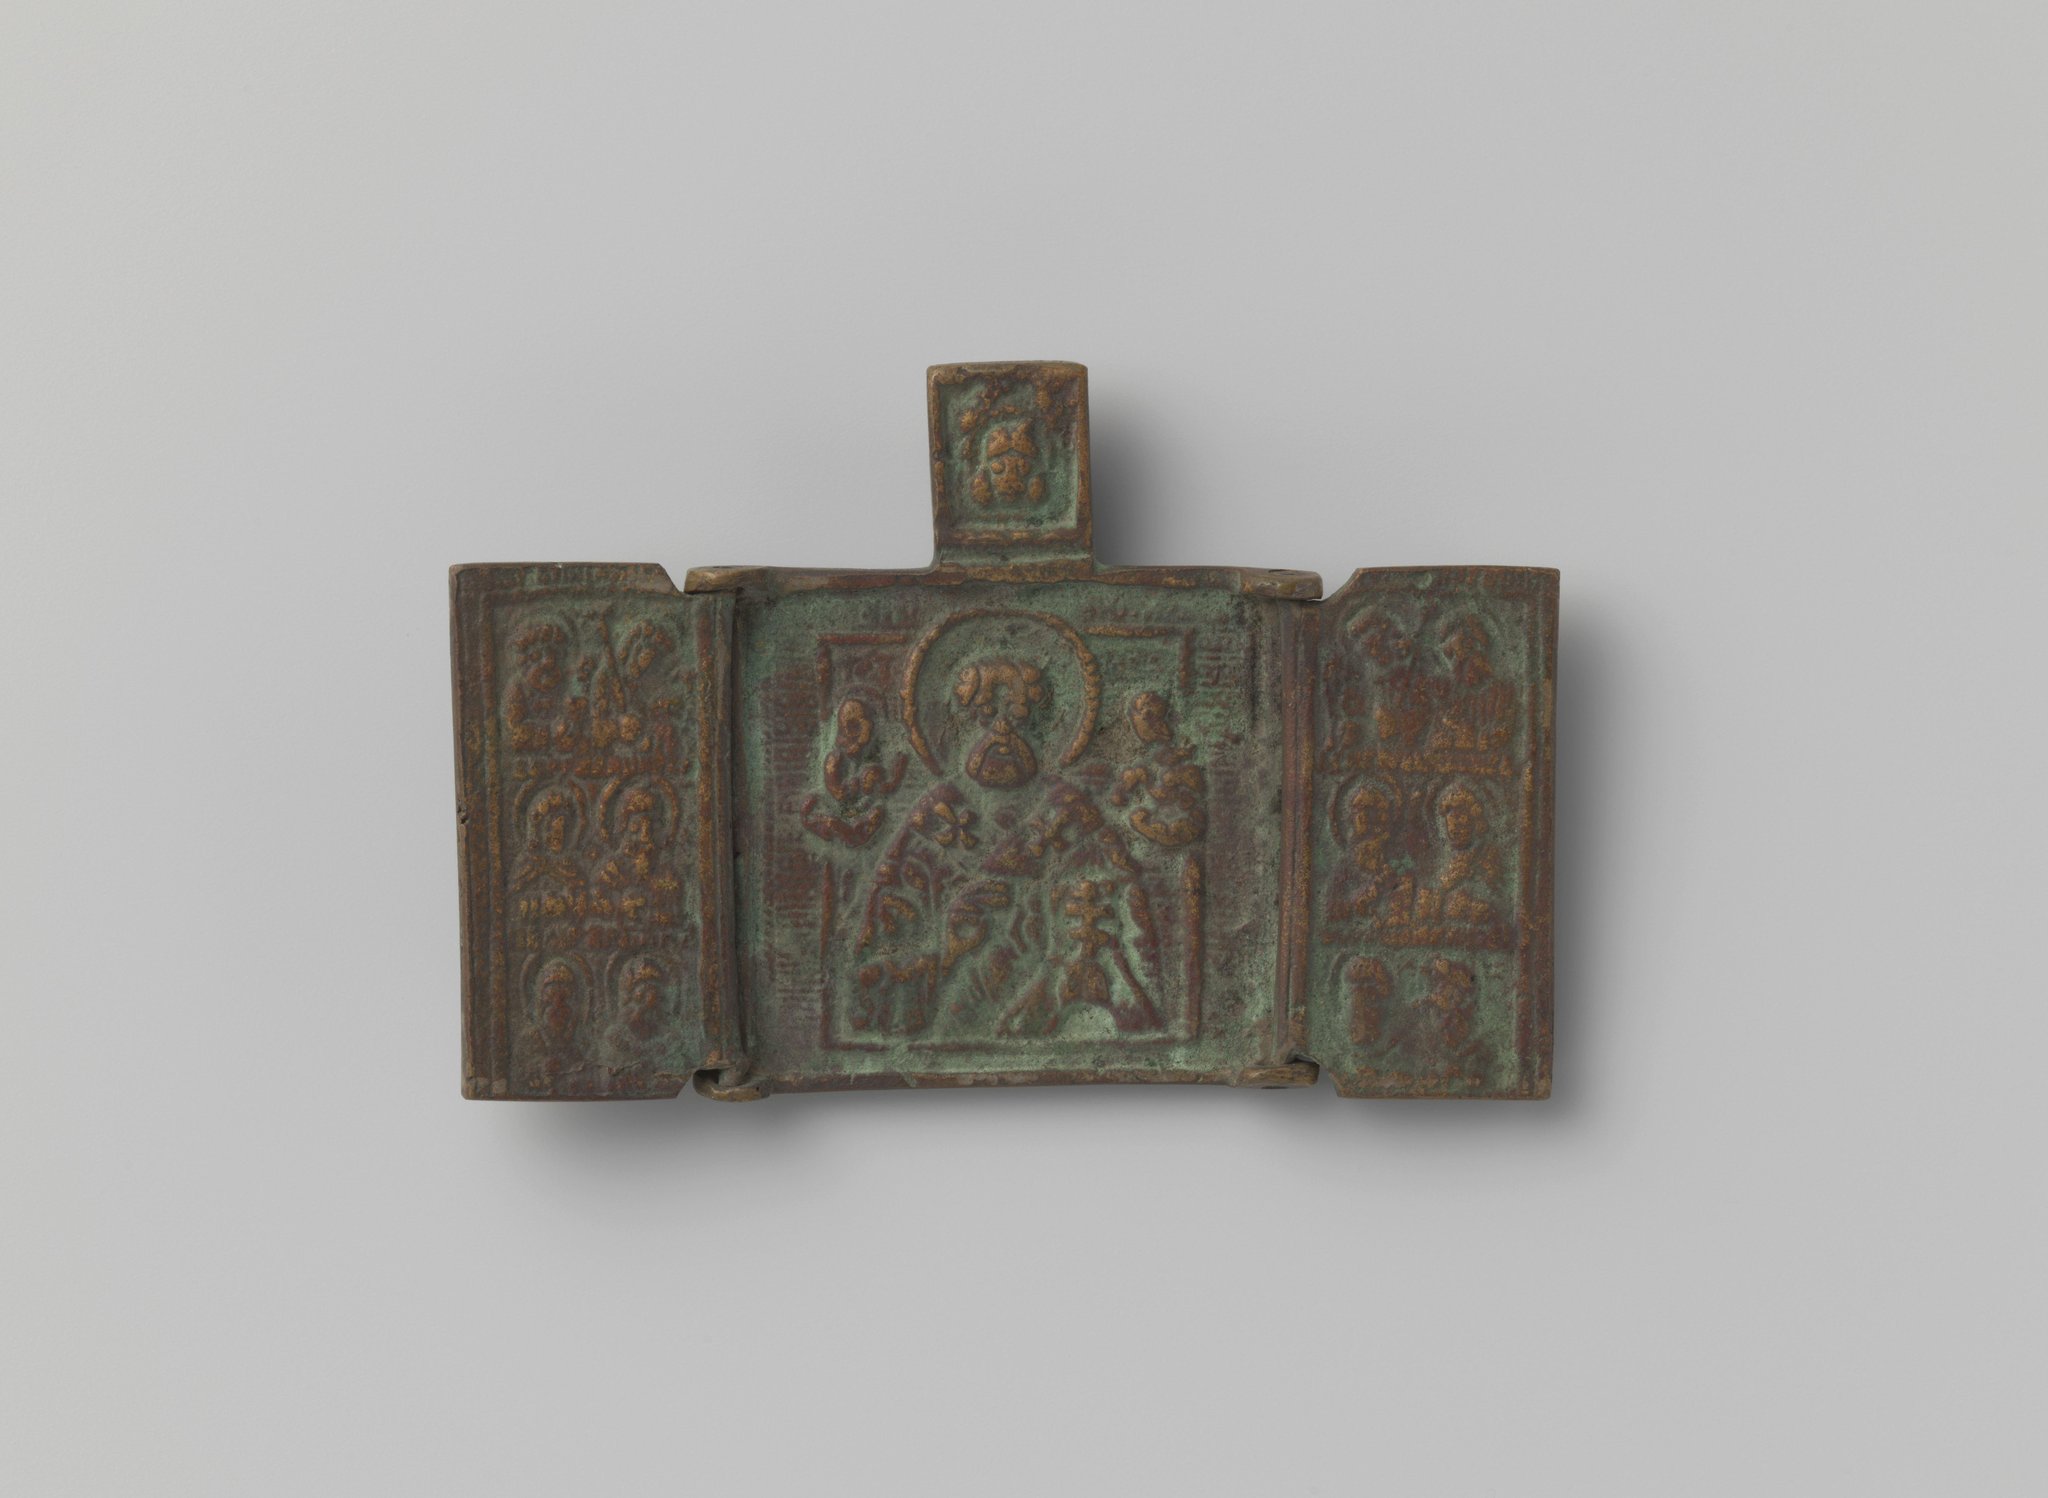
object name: reisicoon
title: Triptiek met de heilige Nicolaas en de twaalf heiligen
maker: Anonymous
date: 1800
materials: copper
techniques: casting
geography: russia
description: Het in drie delen gegoten voorwerp, dat als reisicoon werd gebruikt, bestaat uit een middenluik met een bovenstuk en twee zijluikjes. Het middendeel stelt de H. Nicolaas voor, de zijluikjes de twaalf heiligen, het bovenstuk het hoofd van Christus (het Mandilion)